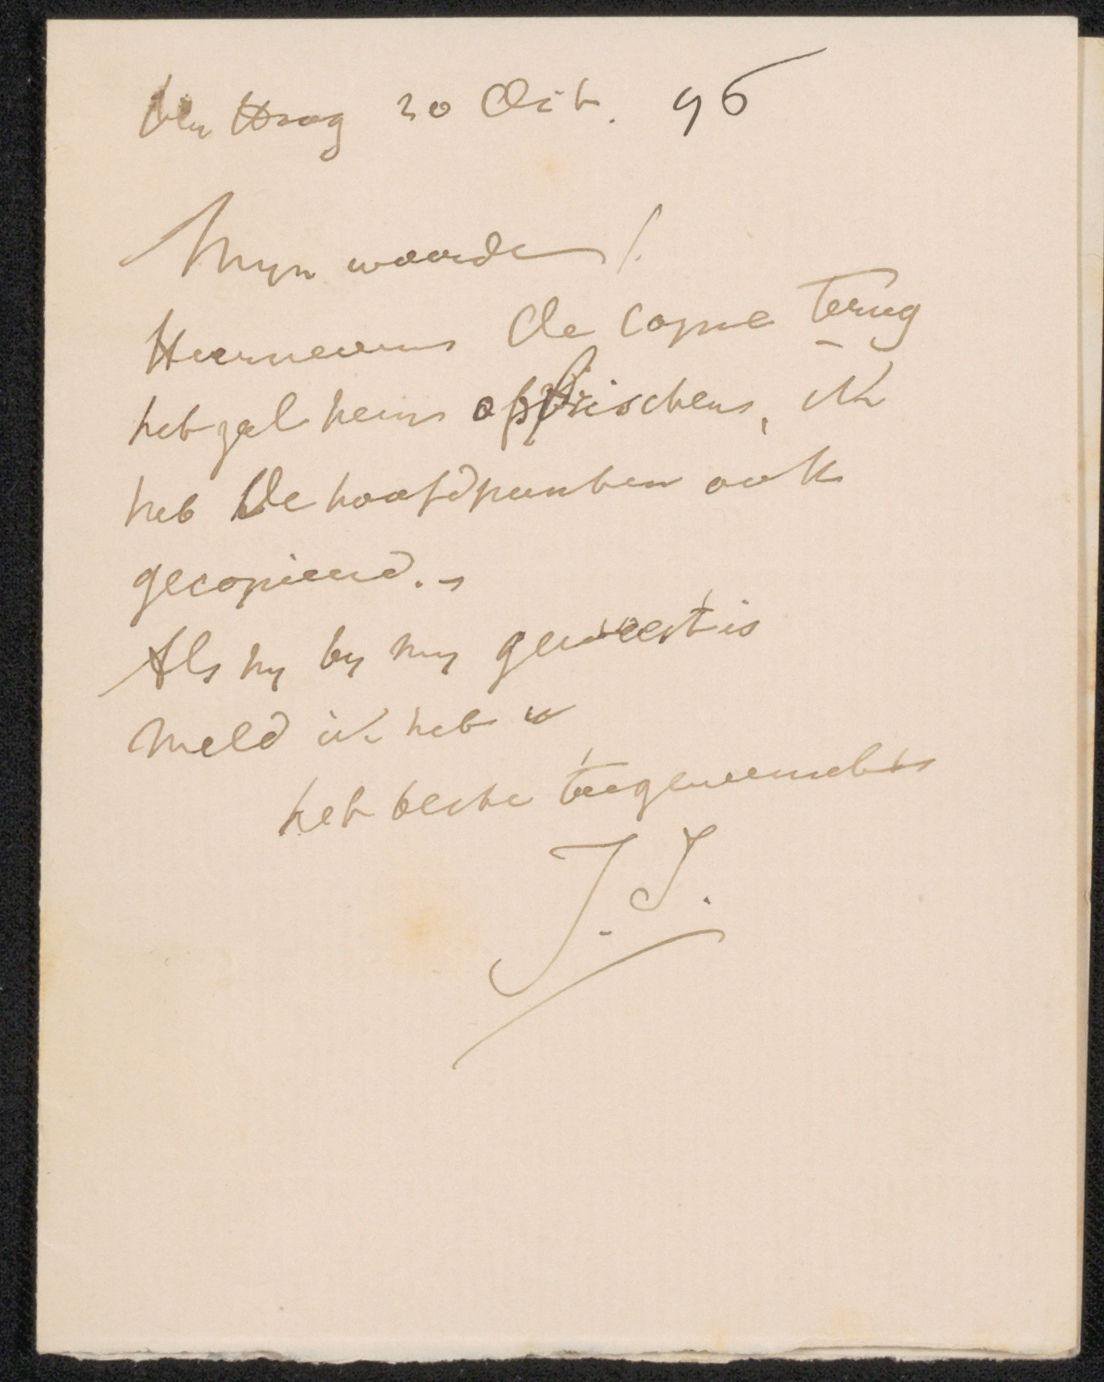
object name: letter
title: Brief aan Jan Veth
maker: jozef israëls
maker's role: draughtsman, painter, print maker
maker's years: 1824-1911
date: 1896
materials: ink, paper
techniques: pen, writing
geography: the hague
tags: dordrecht, amsterdam, designer, jan veth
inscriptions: collector's mark: ‘RPK’